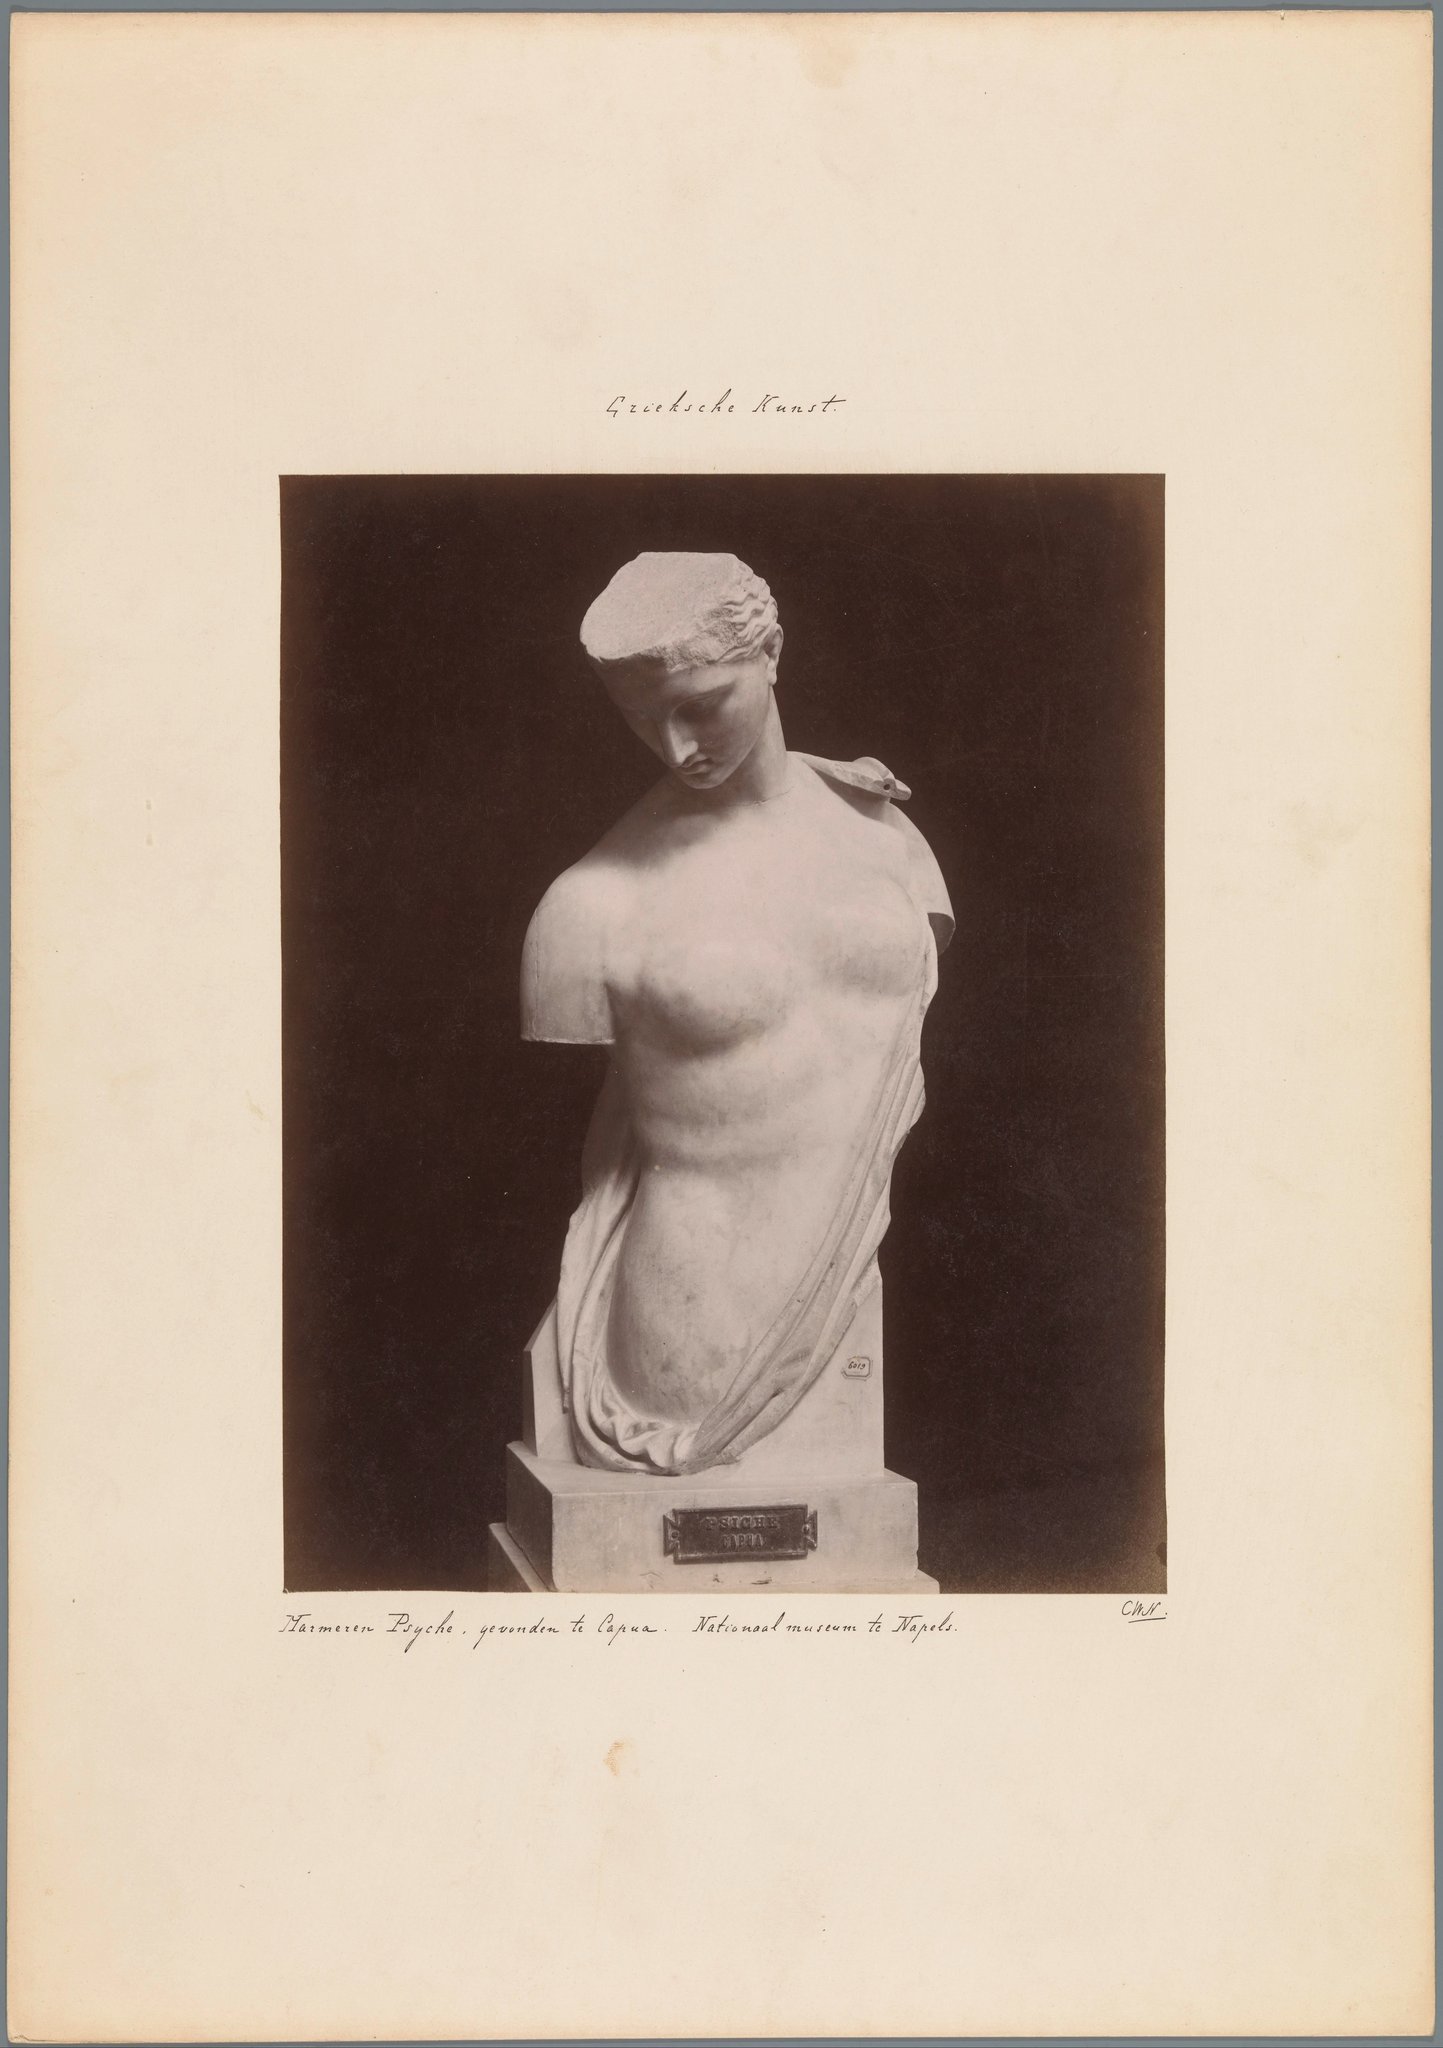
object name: photograph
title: Beeld van Psyche in het Museo Nazionale te Napels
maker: Anonymous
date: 1875-1900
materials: cardboard, photographic support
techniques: albumen print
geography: naples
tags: psyche, woman (showing herself) undressed, quasi-nude, sculpture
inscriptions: inscription: ‘CWN.’, collector's mark: ‘INSTITUUT VOOR KUNST- NIJVERHEIDSONDERWIJS GABRIËL METSUSTRAAT No. 16. AMSTERDAM’, collector's mark: ‘KUNSTNIJVERHEIDSCHOOL QUELLINUS AMSTERDAM FRANS HALSSTRAAT 14.’, inscription: ‘Grieksche Kunst. Marmeren Psyche, gevonden te Capua. Nationaal museum te Napels.’